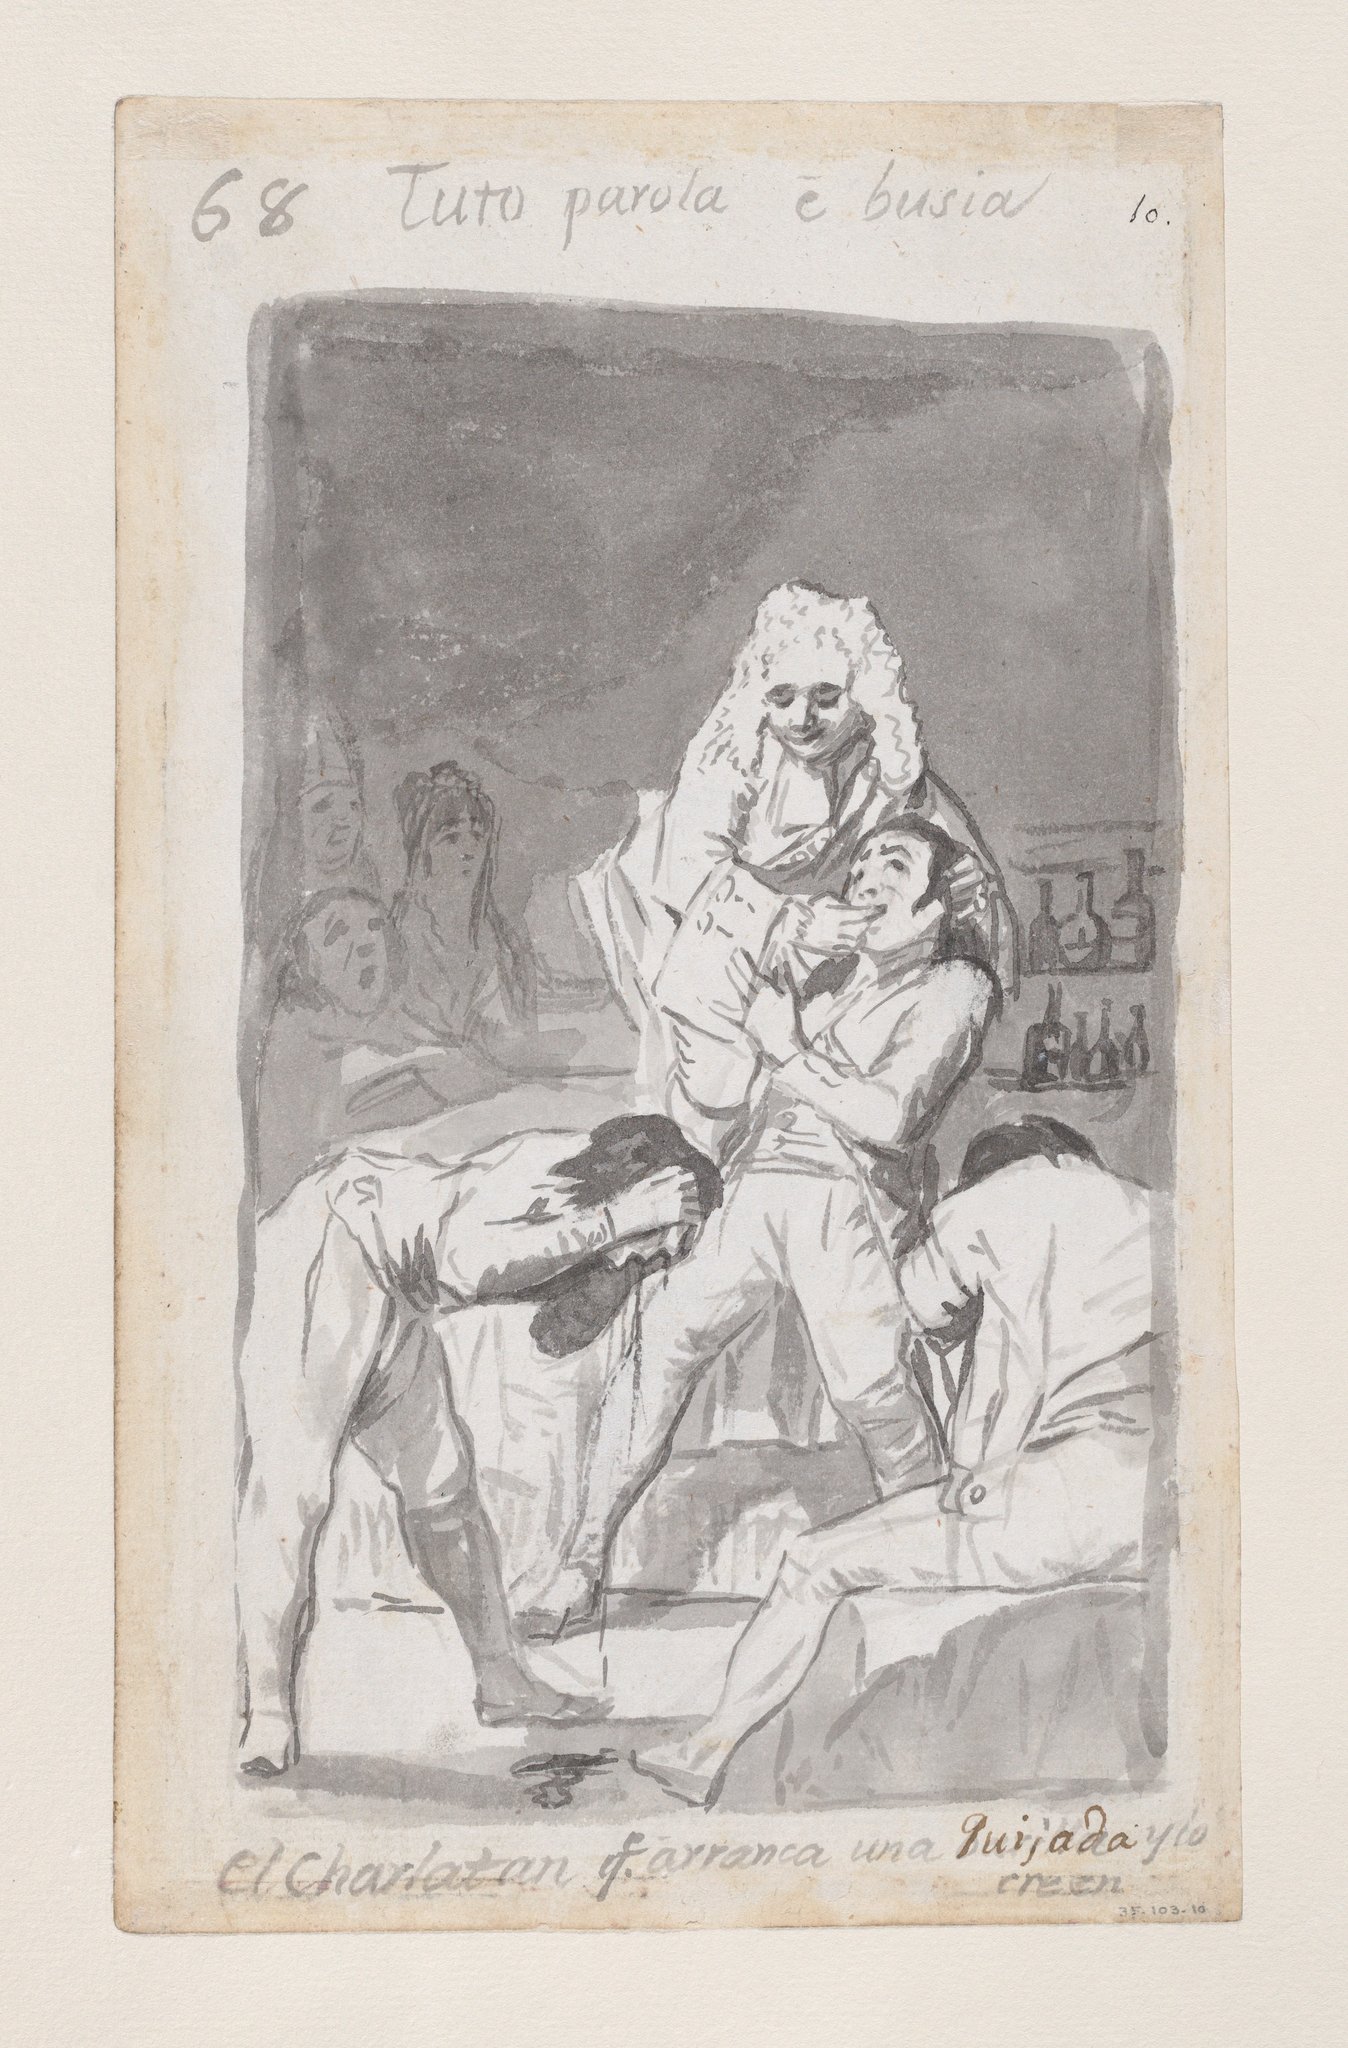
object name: drawing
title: A charlatan extracting a tooth from a patient's mouth, figure in the foreground vomiting; folio 68 (verso) from the Madrid Album "B"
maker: goya (francisco de goya y lucientes)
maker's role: artist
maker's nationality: spanish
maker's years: 1746-1828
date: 1796-1798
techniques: brush, wash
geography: spain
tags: men